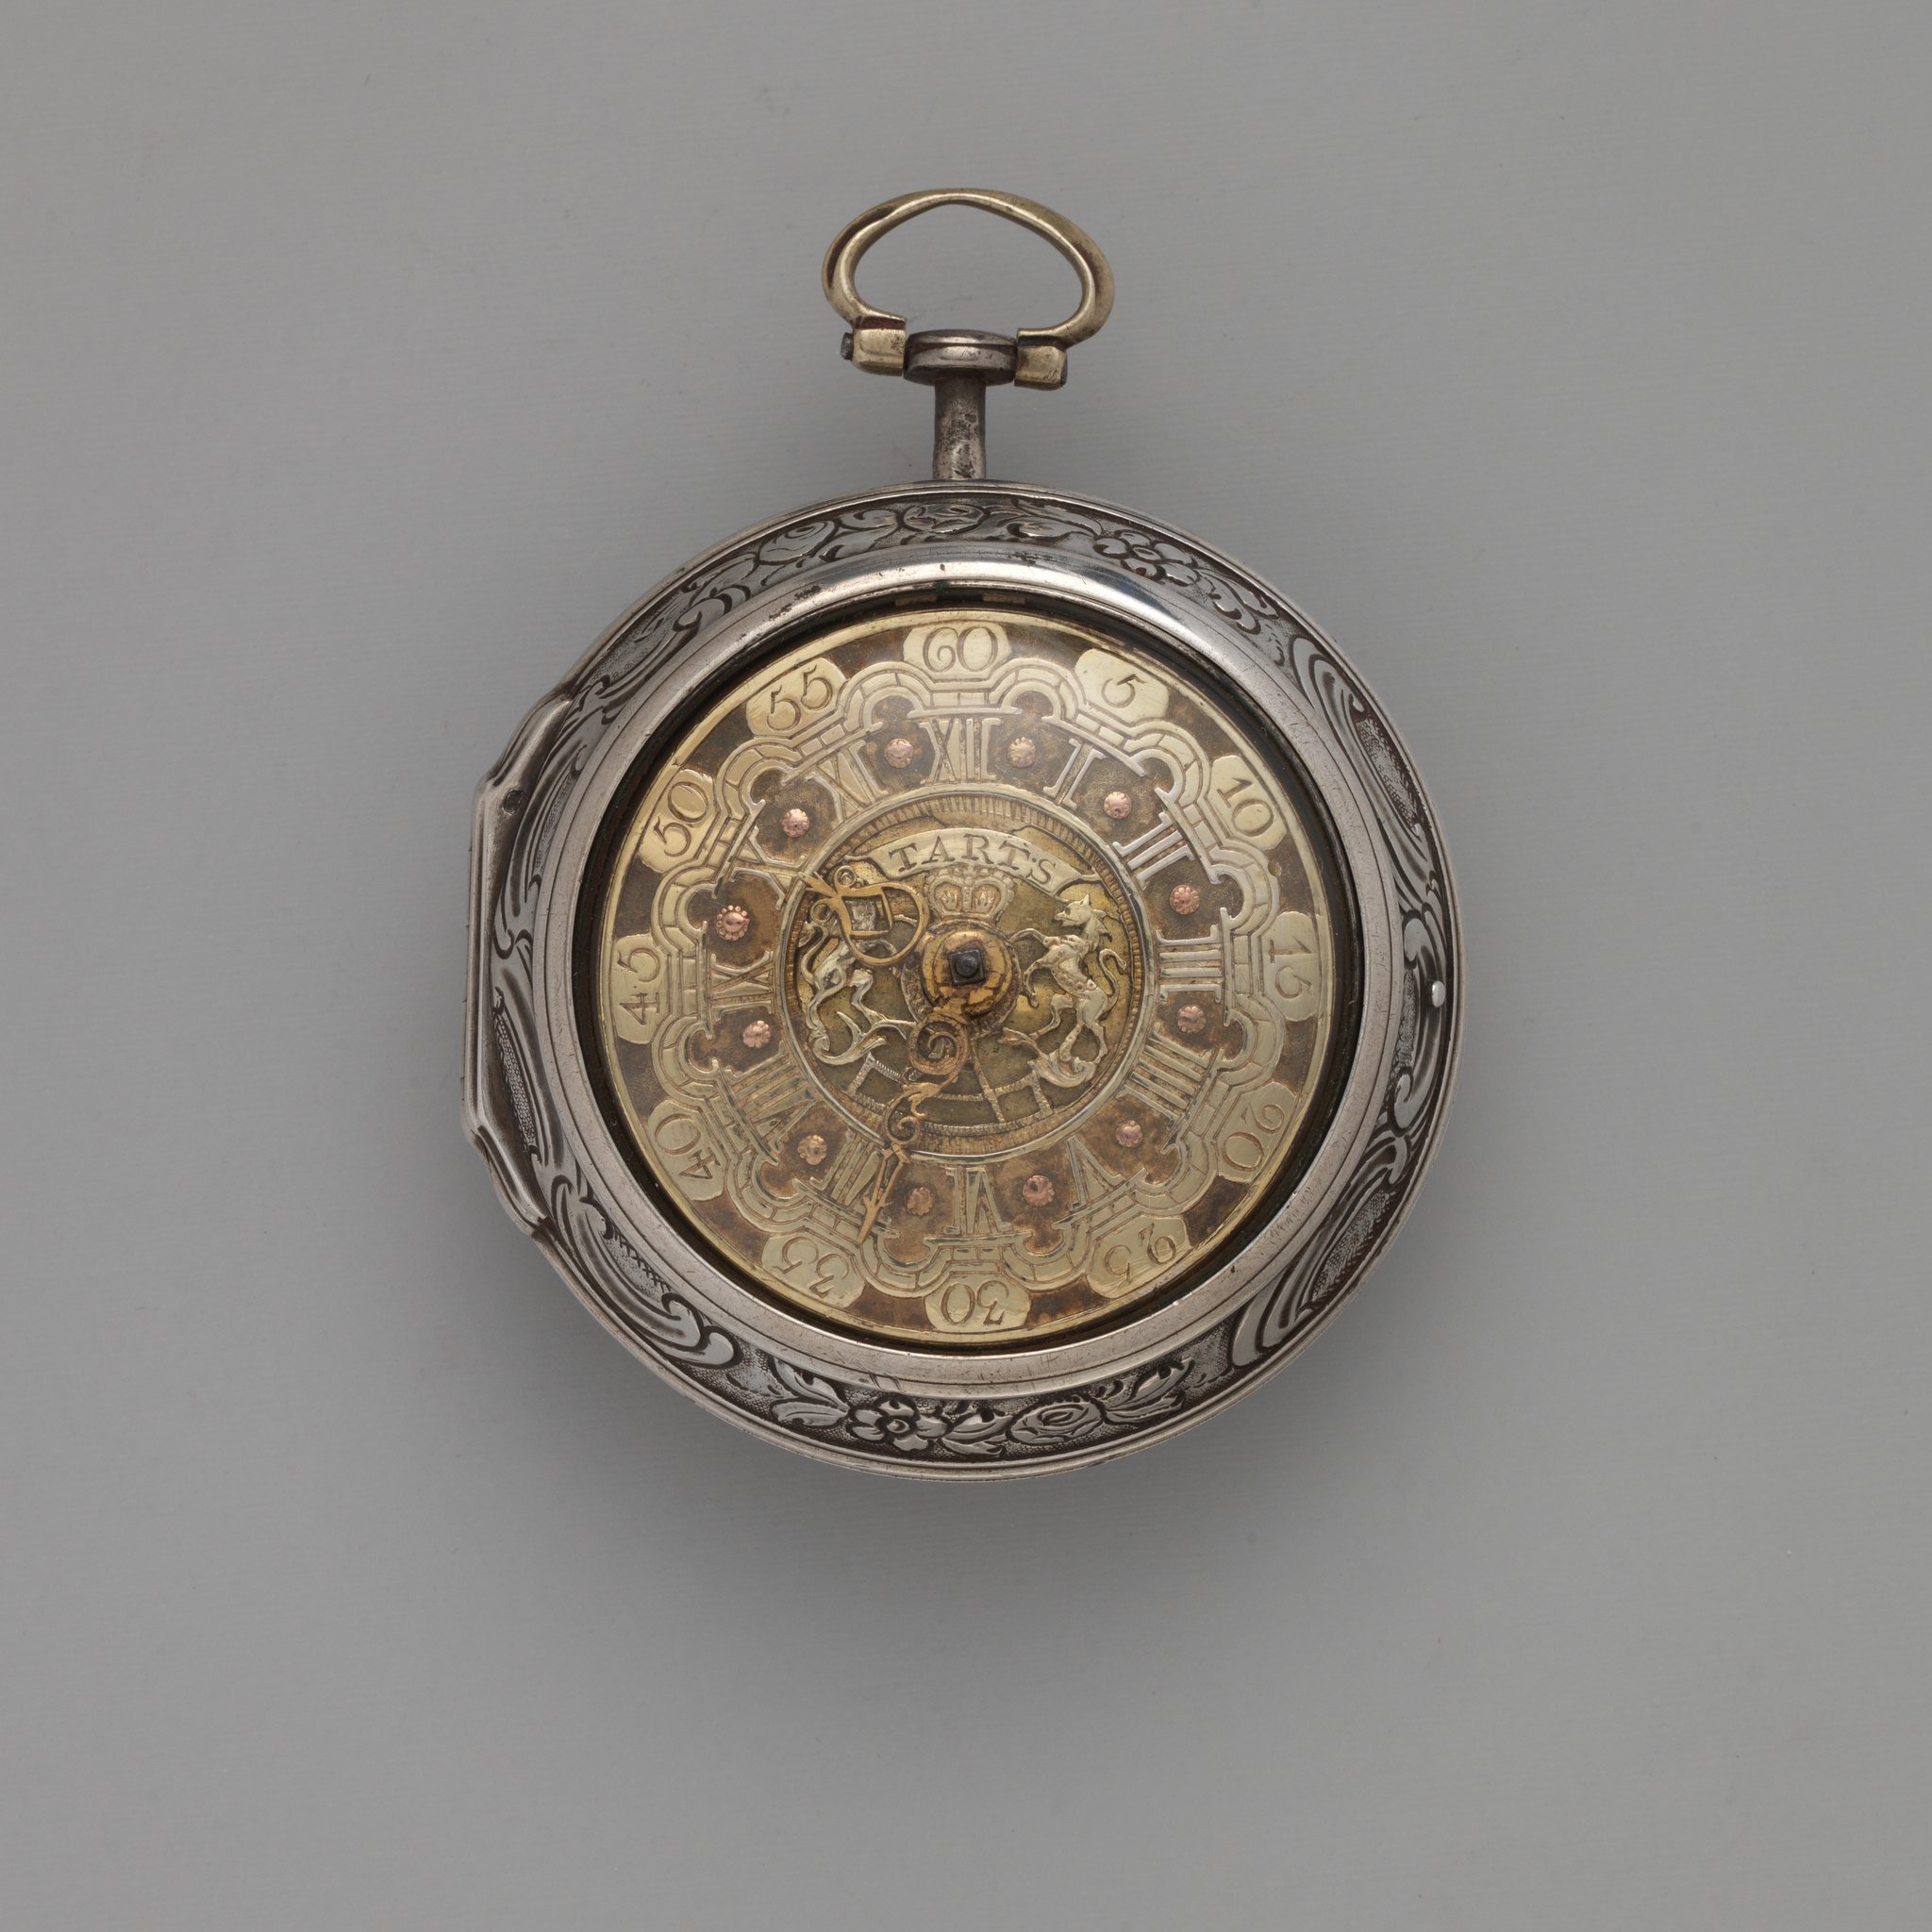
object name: watch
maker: j. tarts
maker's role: maker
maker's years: 1755-1790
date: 1774-1775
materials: brass, silver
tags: horses,coat of arms